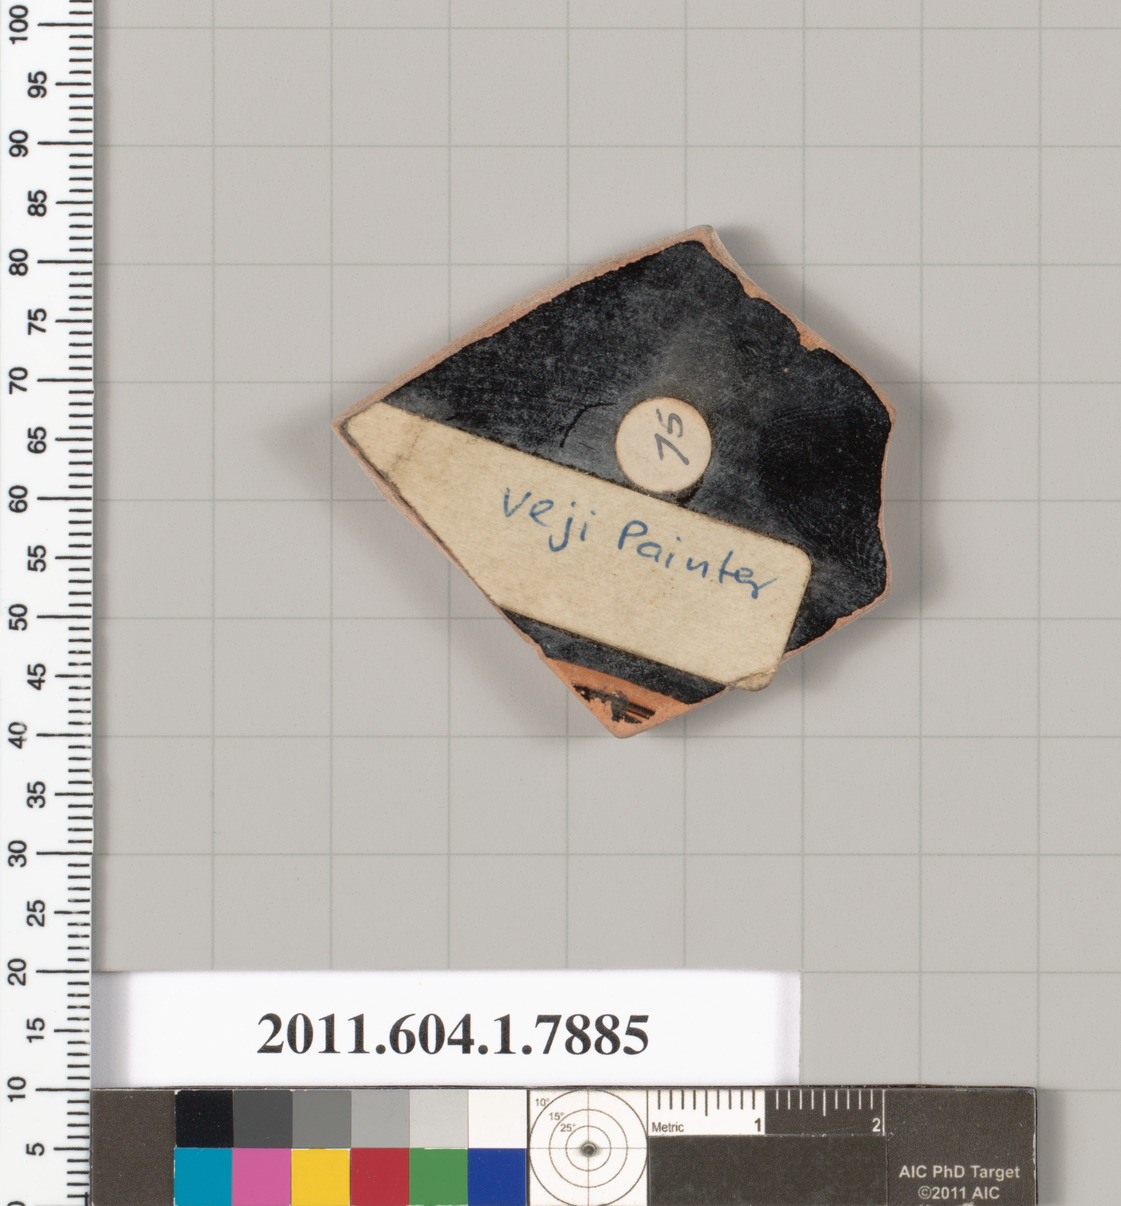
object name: kylix fragment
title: Terracotta fragment of a kylix (drinking cup)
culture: greek, attic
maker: veii painter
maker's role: artist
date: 460-450 BCE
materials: terracotta